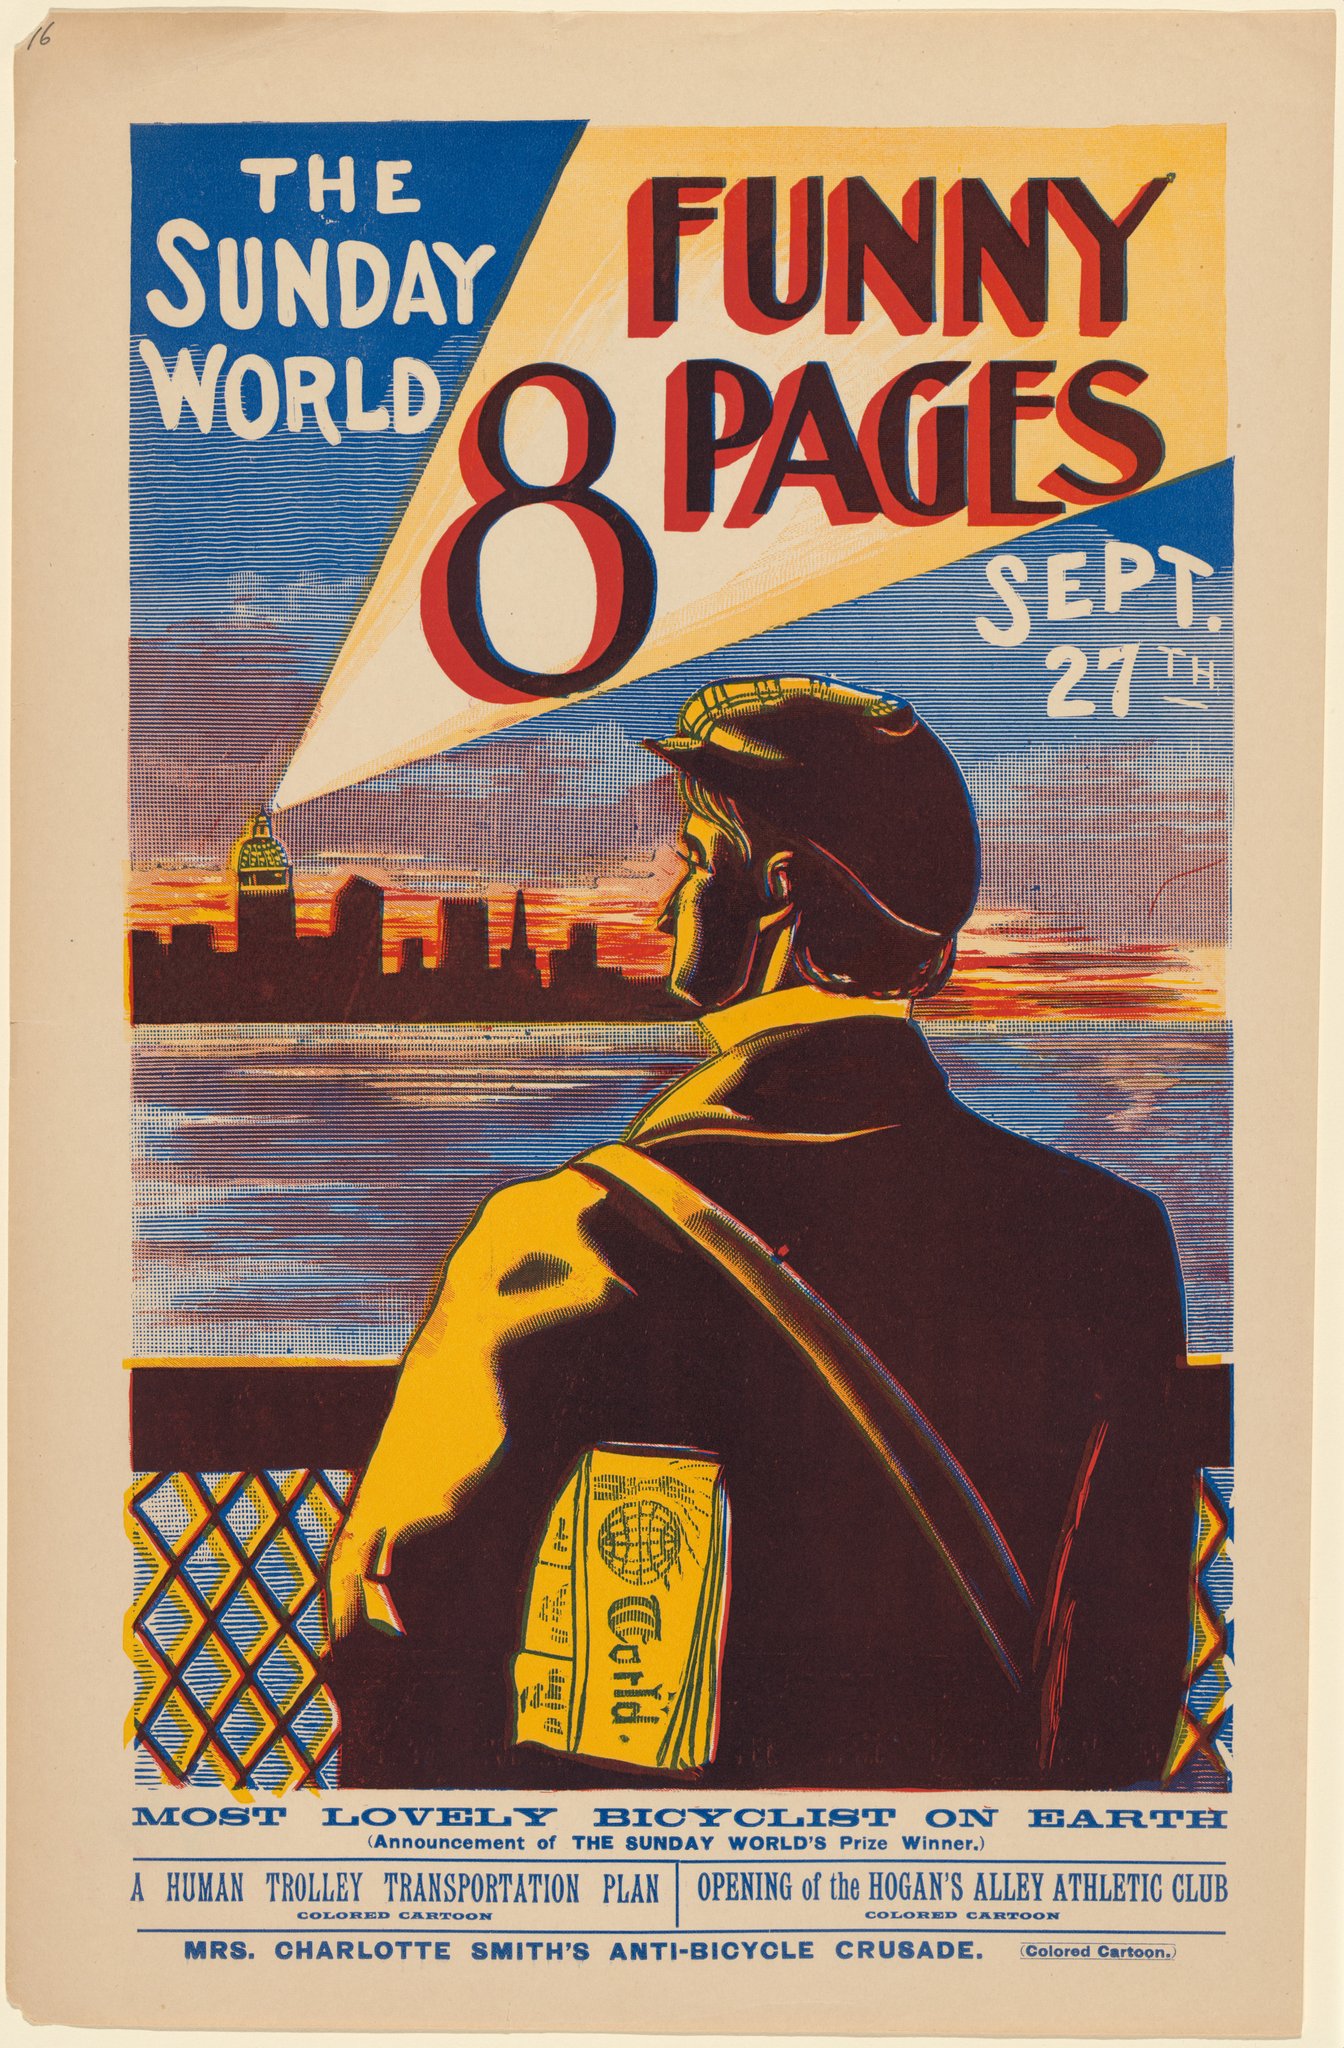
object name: print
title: The Sunday World, Most Lovely Bicyclist on Earth: Announcement of The Sunday World Prize Winner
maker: anonymous, american, 19th century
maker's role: artist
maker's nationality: american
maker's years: 1800-1900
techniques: letterpress